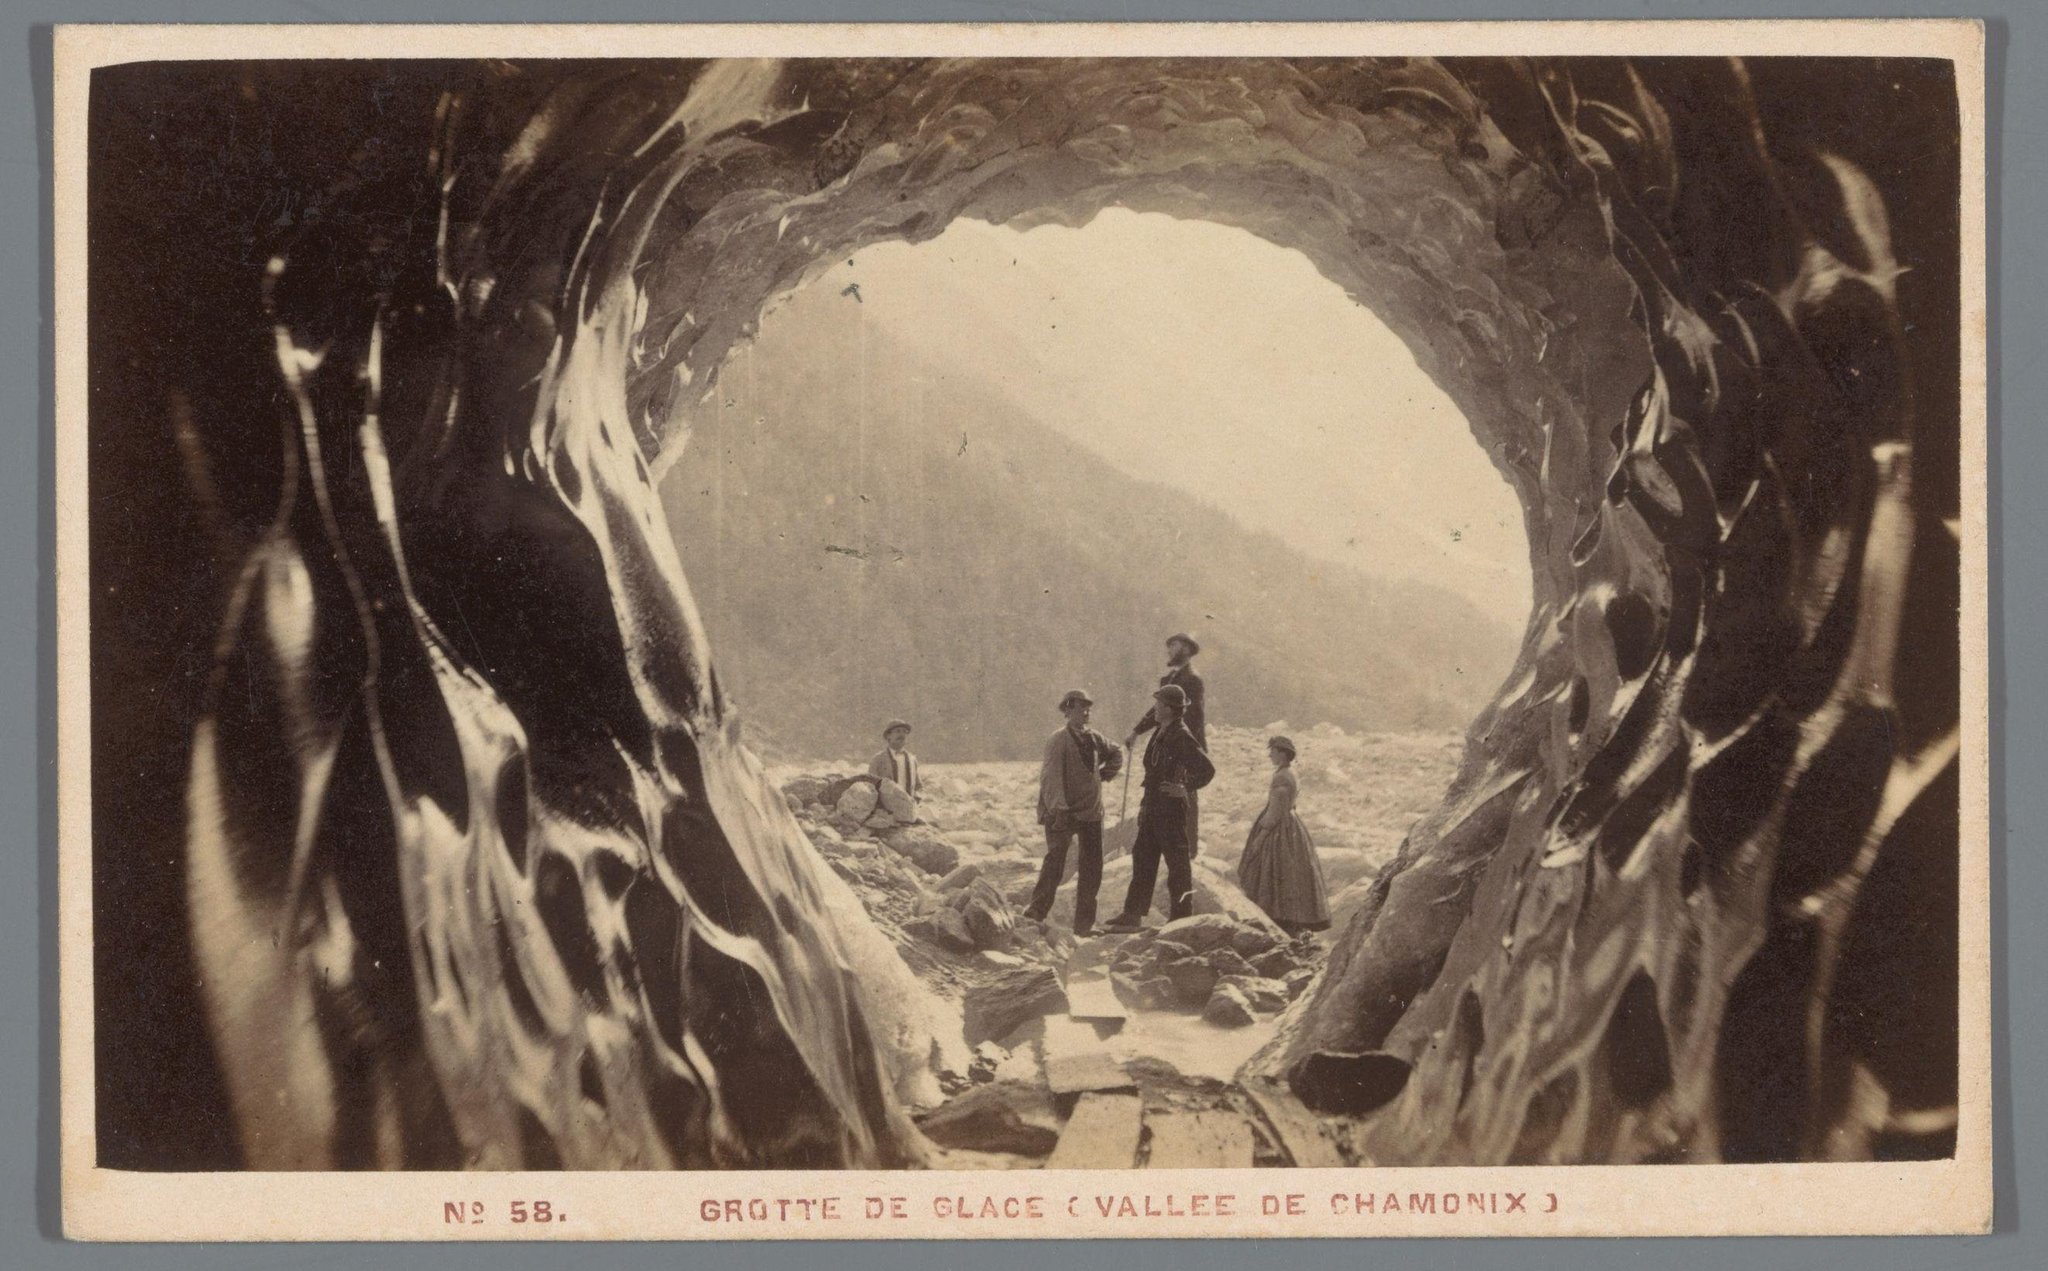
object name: photograph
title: Gletsjergrot nabij Chamonix, Frankrijk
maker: auguste garcin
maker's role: fotograaf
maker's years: 1816-1895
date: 1855-1885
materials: cardboard, paper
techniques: albumen print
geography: chamonix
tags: glacier, cave, grotto (+ landscape with figures, staffage)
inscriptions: number: ‘No. 58.’, inscription: ‘SUISSE SAVOIE/ GARCIN/ PHOTOGRAPHE/ À/ GÉNÈVE/ MIDI DE LA FRANCE’